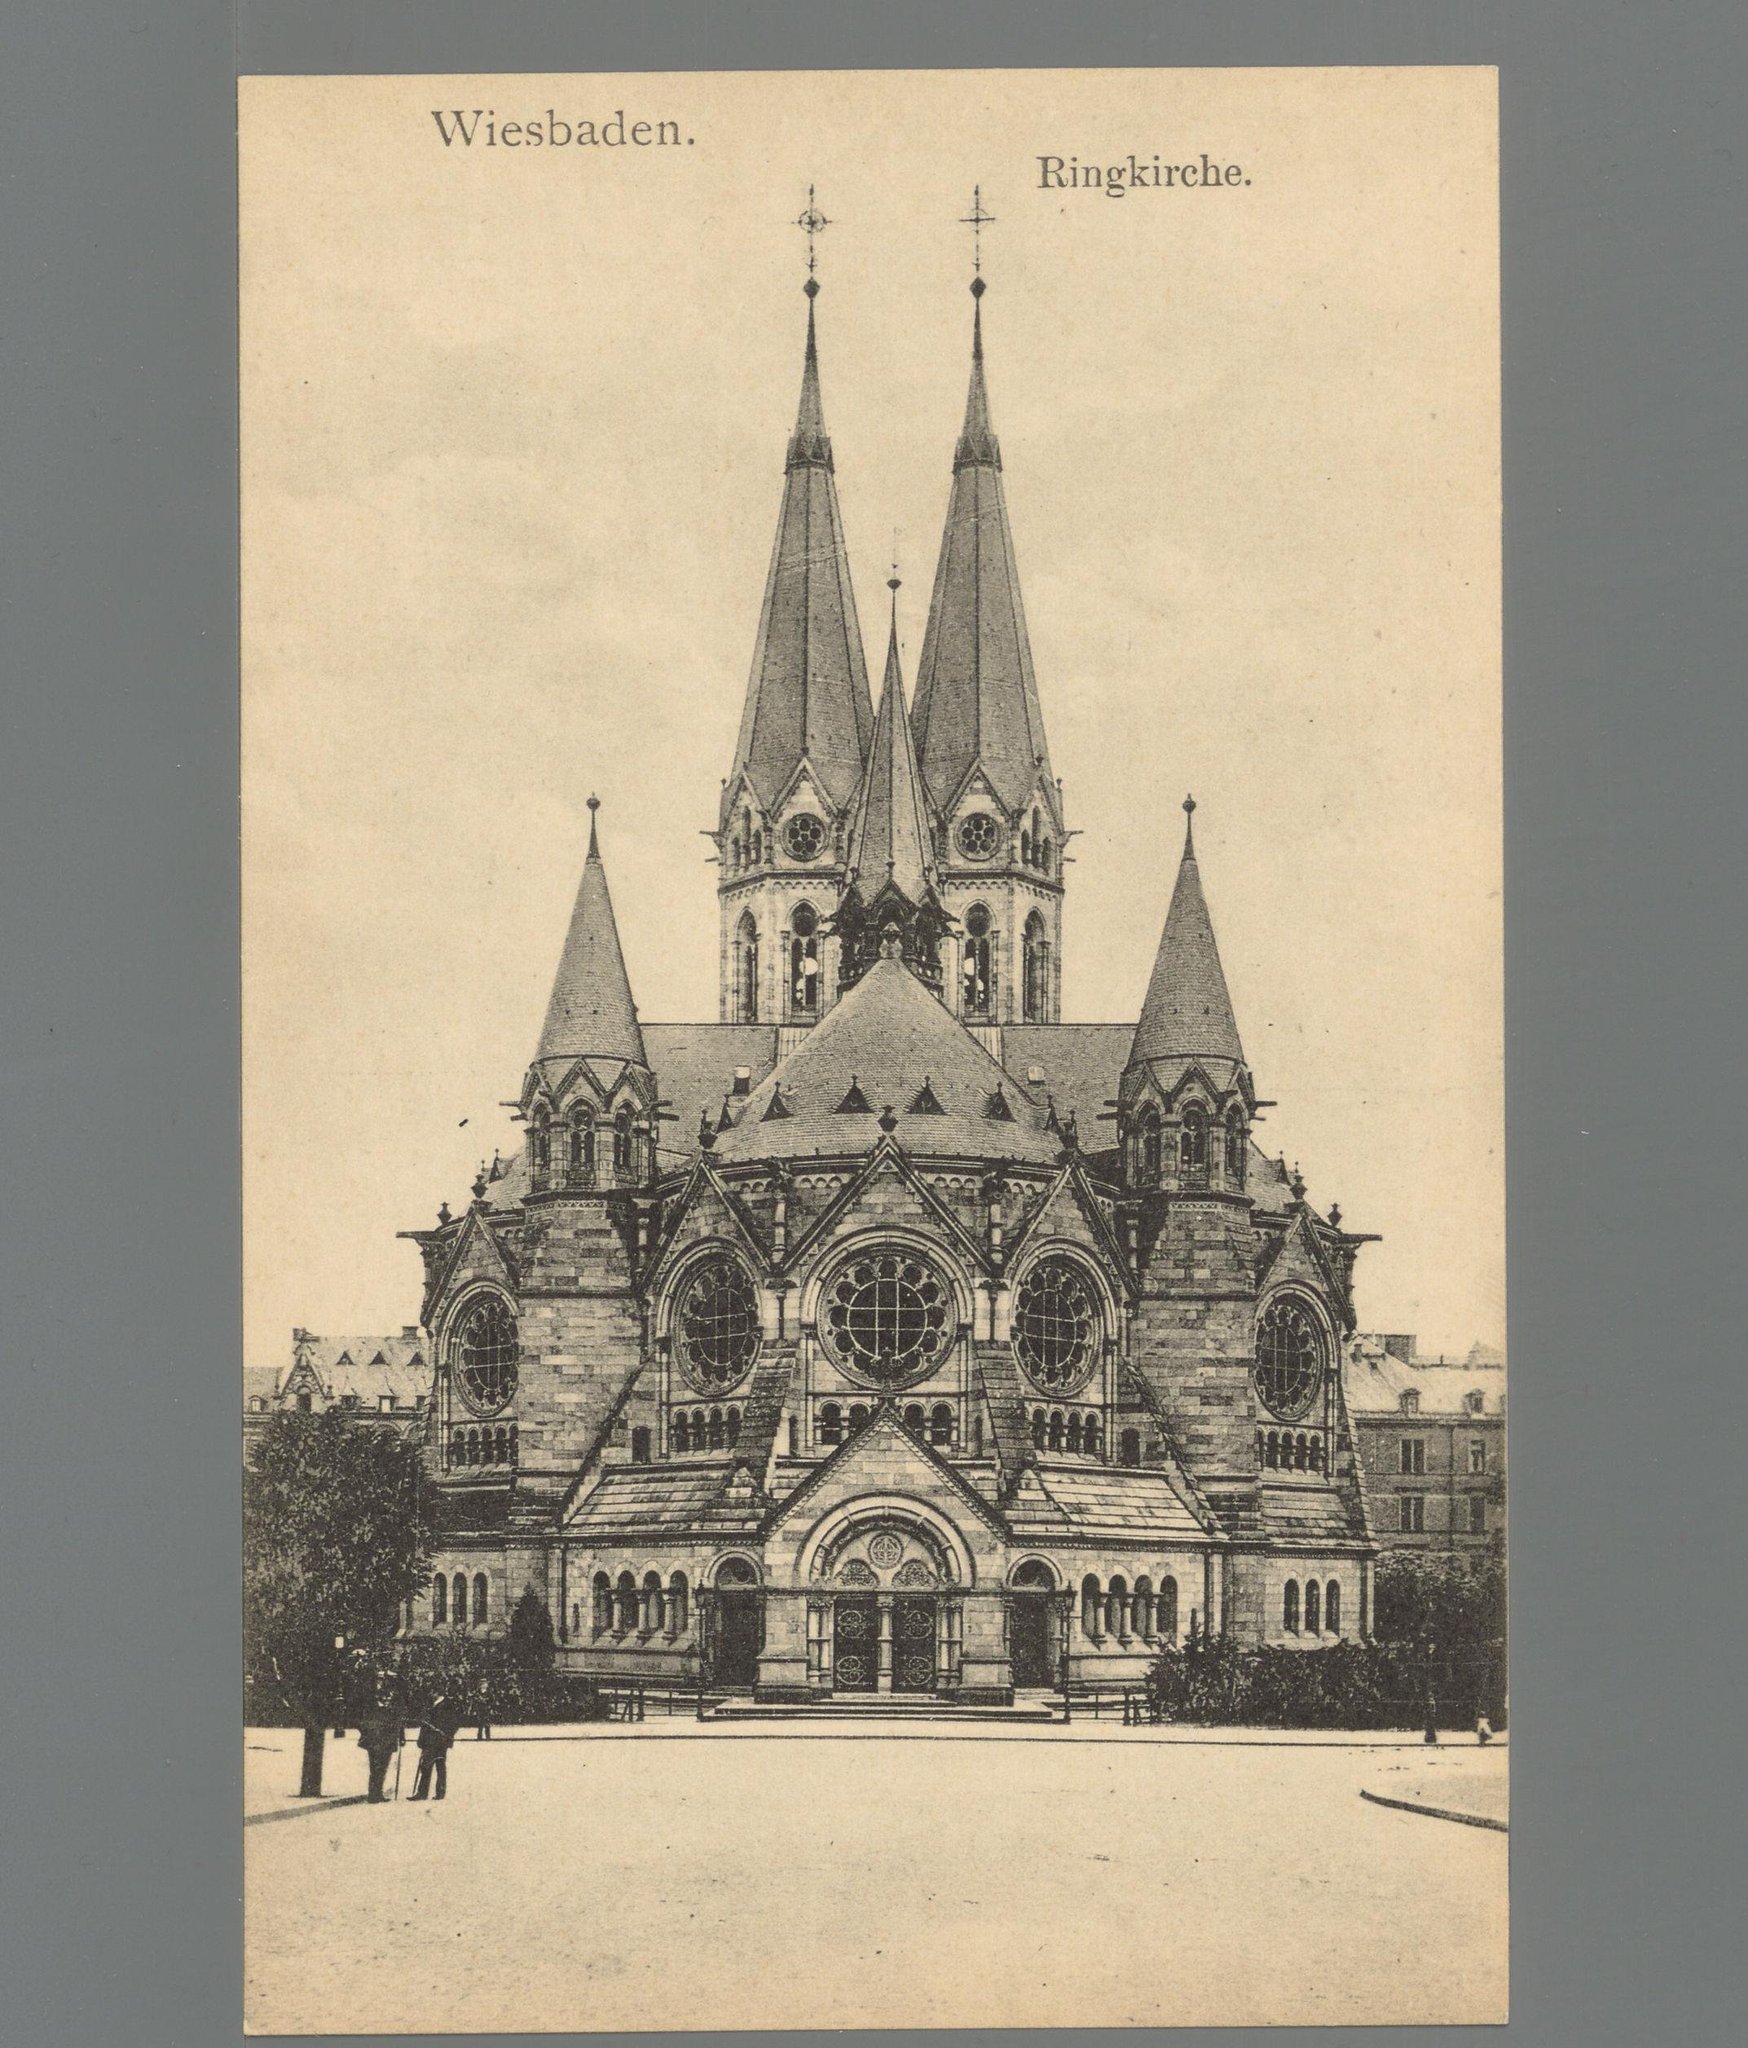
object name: photomechanical print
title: Wiesbaden. Ringkirche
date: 1908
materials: cardboard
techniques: photograph, writing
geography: wiesbaden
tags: church (exterior)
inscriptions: date